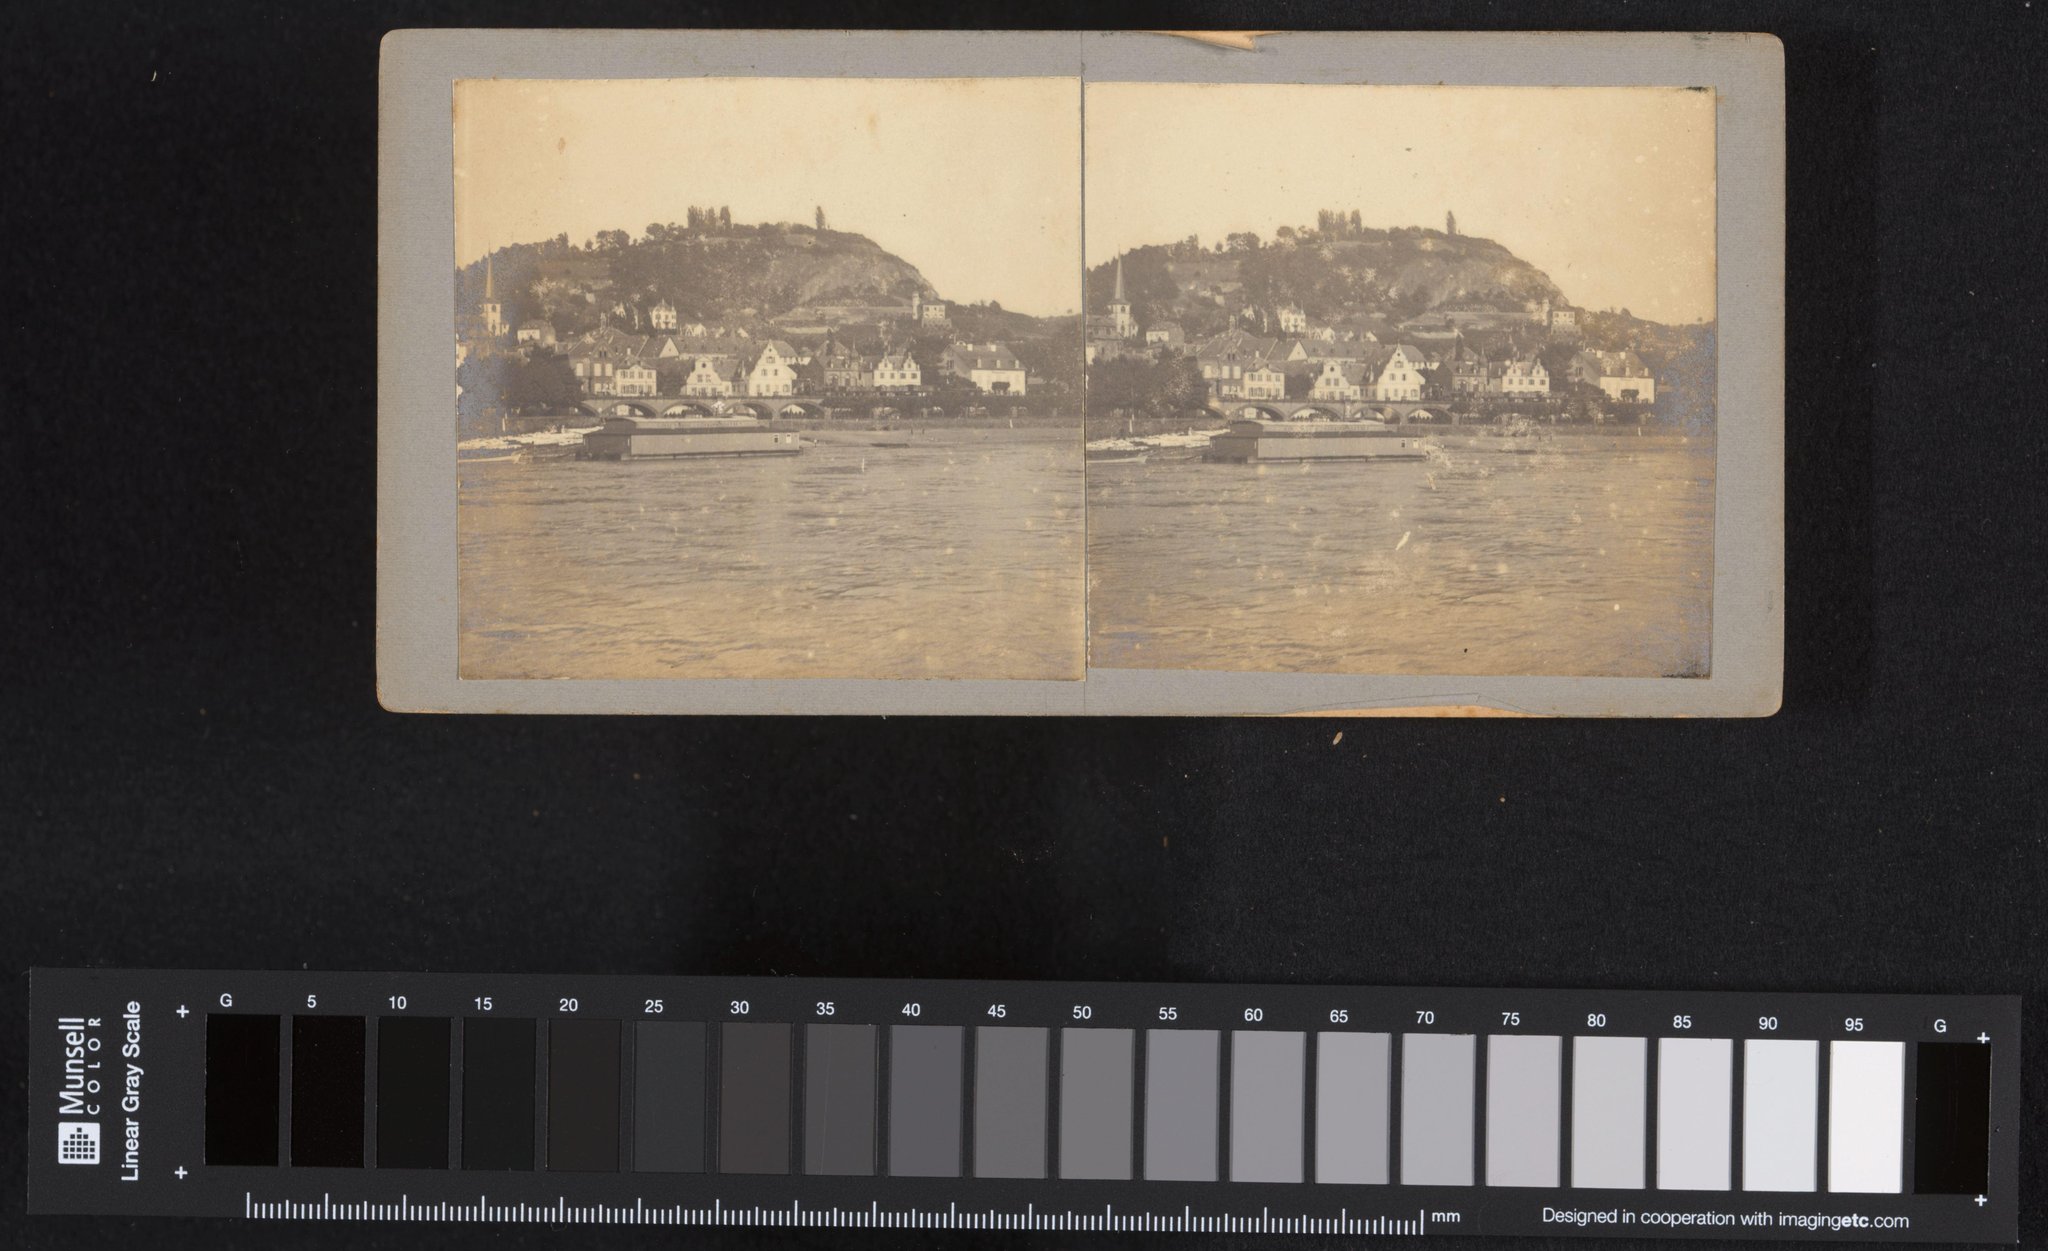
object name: stereograph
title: Rivierlandschap in Duitsland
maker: robert julius boers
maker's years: 1867-1932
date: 1900-1922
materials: cardboard, photographic support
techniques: gelatin silver print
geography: germany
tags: robert julius boers, germany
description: Rivierlandschap, waarschijnlijk de Rijn in Duitsland. Onderdeel van een groep stereofoto's van Robert Julius Boers, chef van het staatsbedrijf de Banka-tinwinning op Banka, uit de periode ca. 1900-1922.